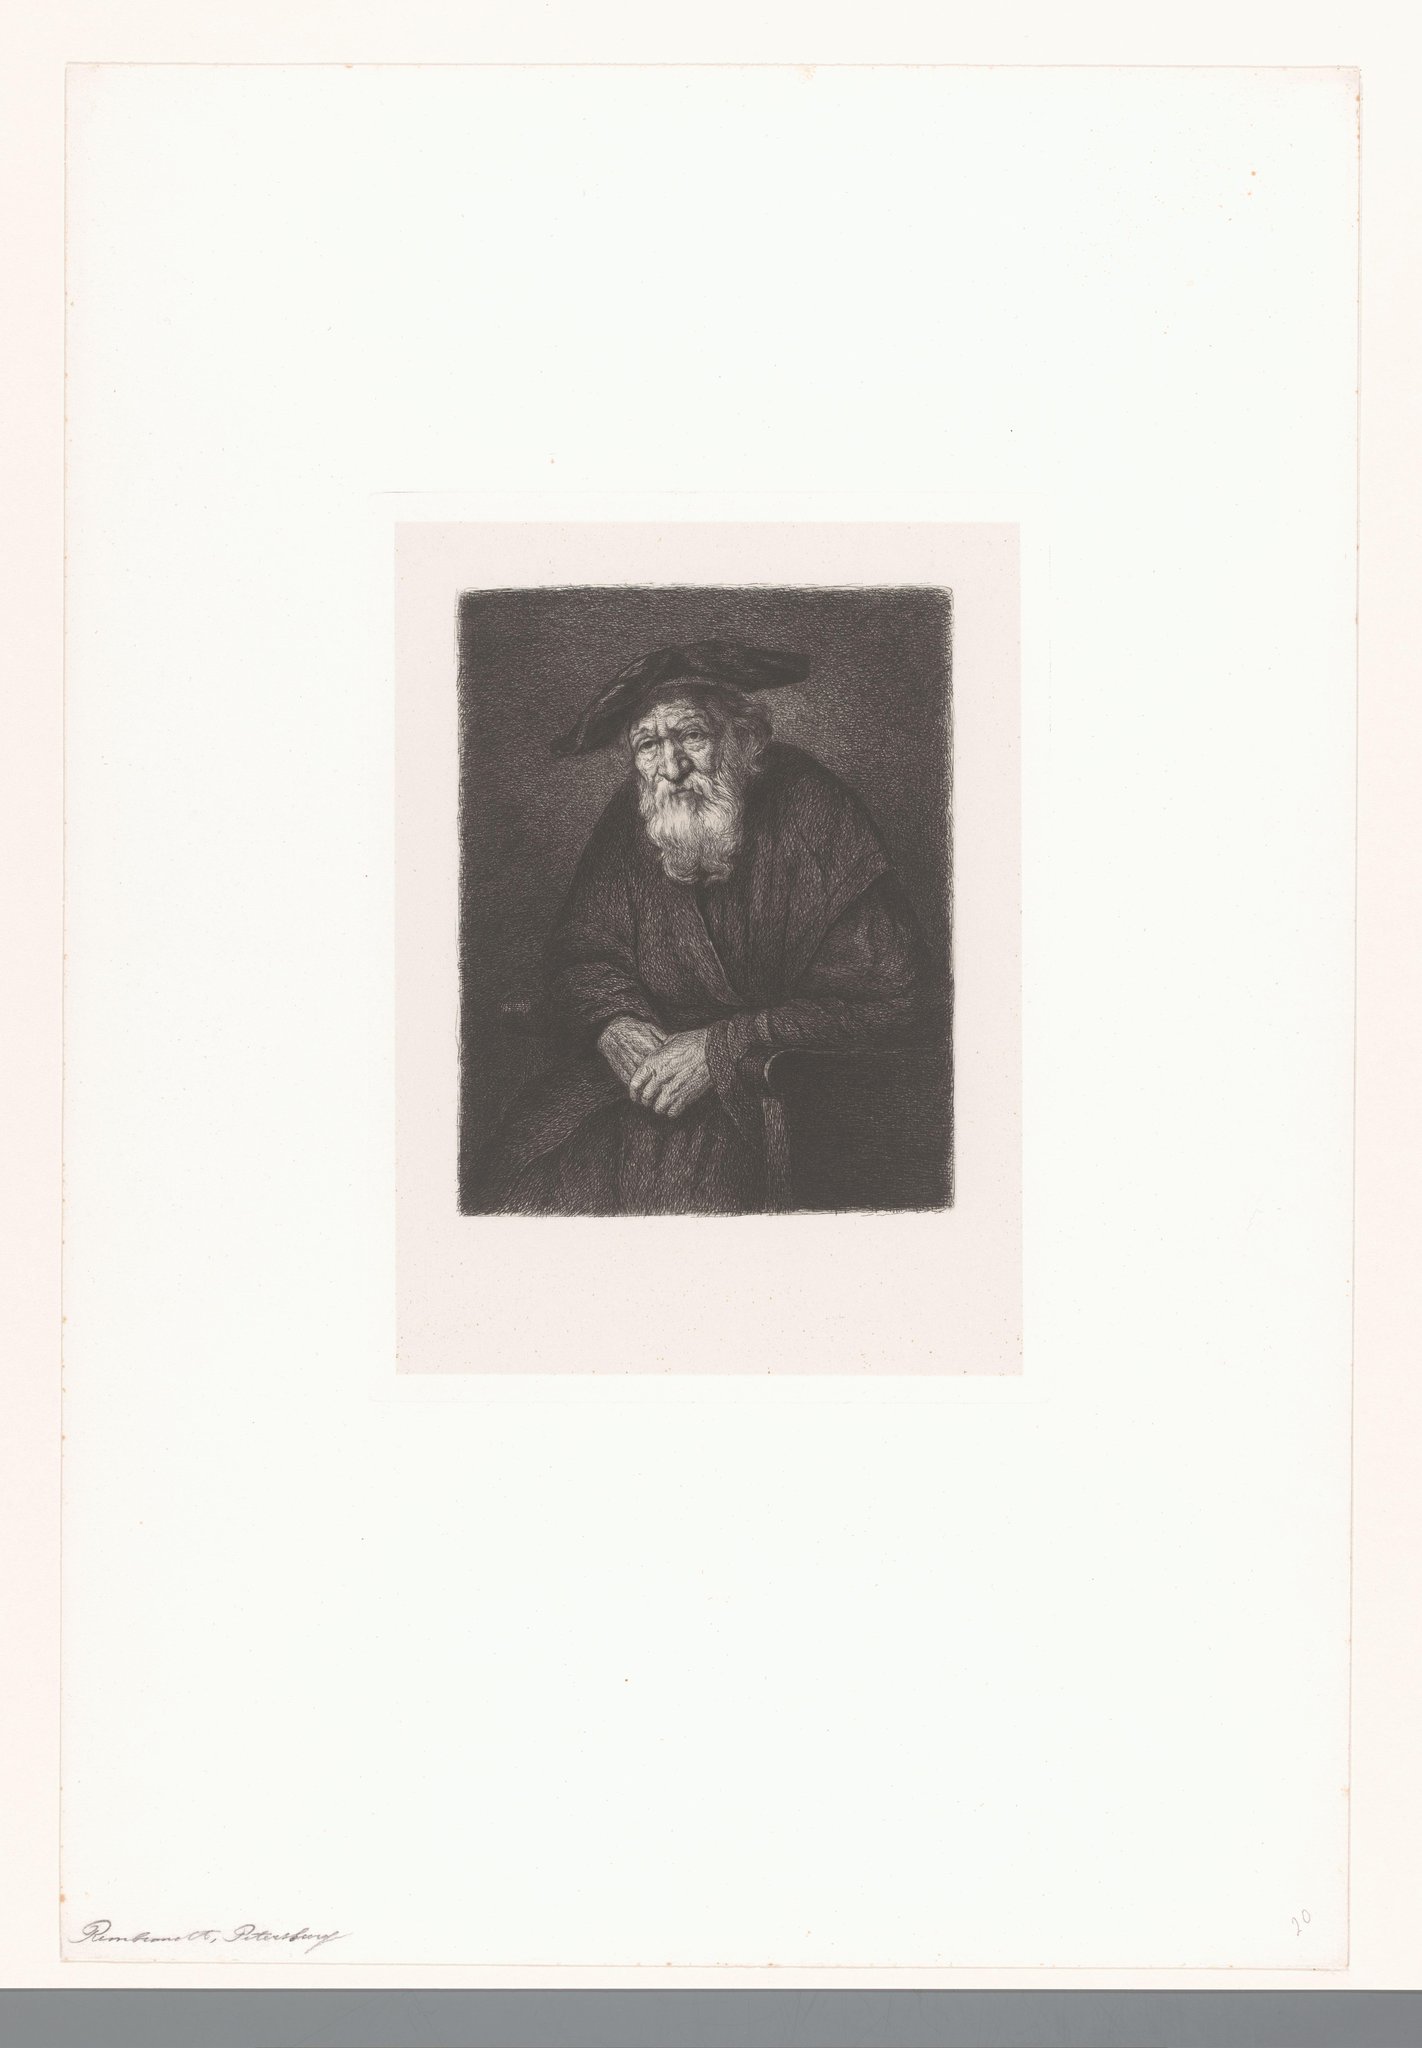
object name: print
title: Portret van een oude Joodse man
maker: nikolay semyonovich mosolov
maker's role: print maker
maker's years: 1847-1914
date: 1857-1914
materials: paper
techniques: drypoint, etching, intaglio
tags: old man, the jews, jewish life